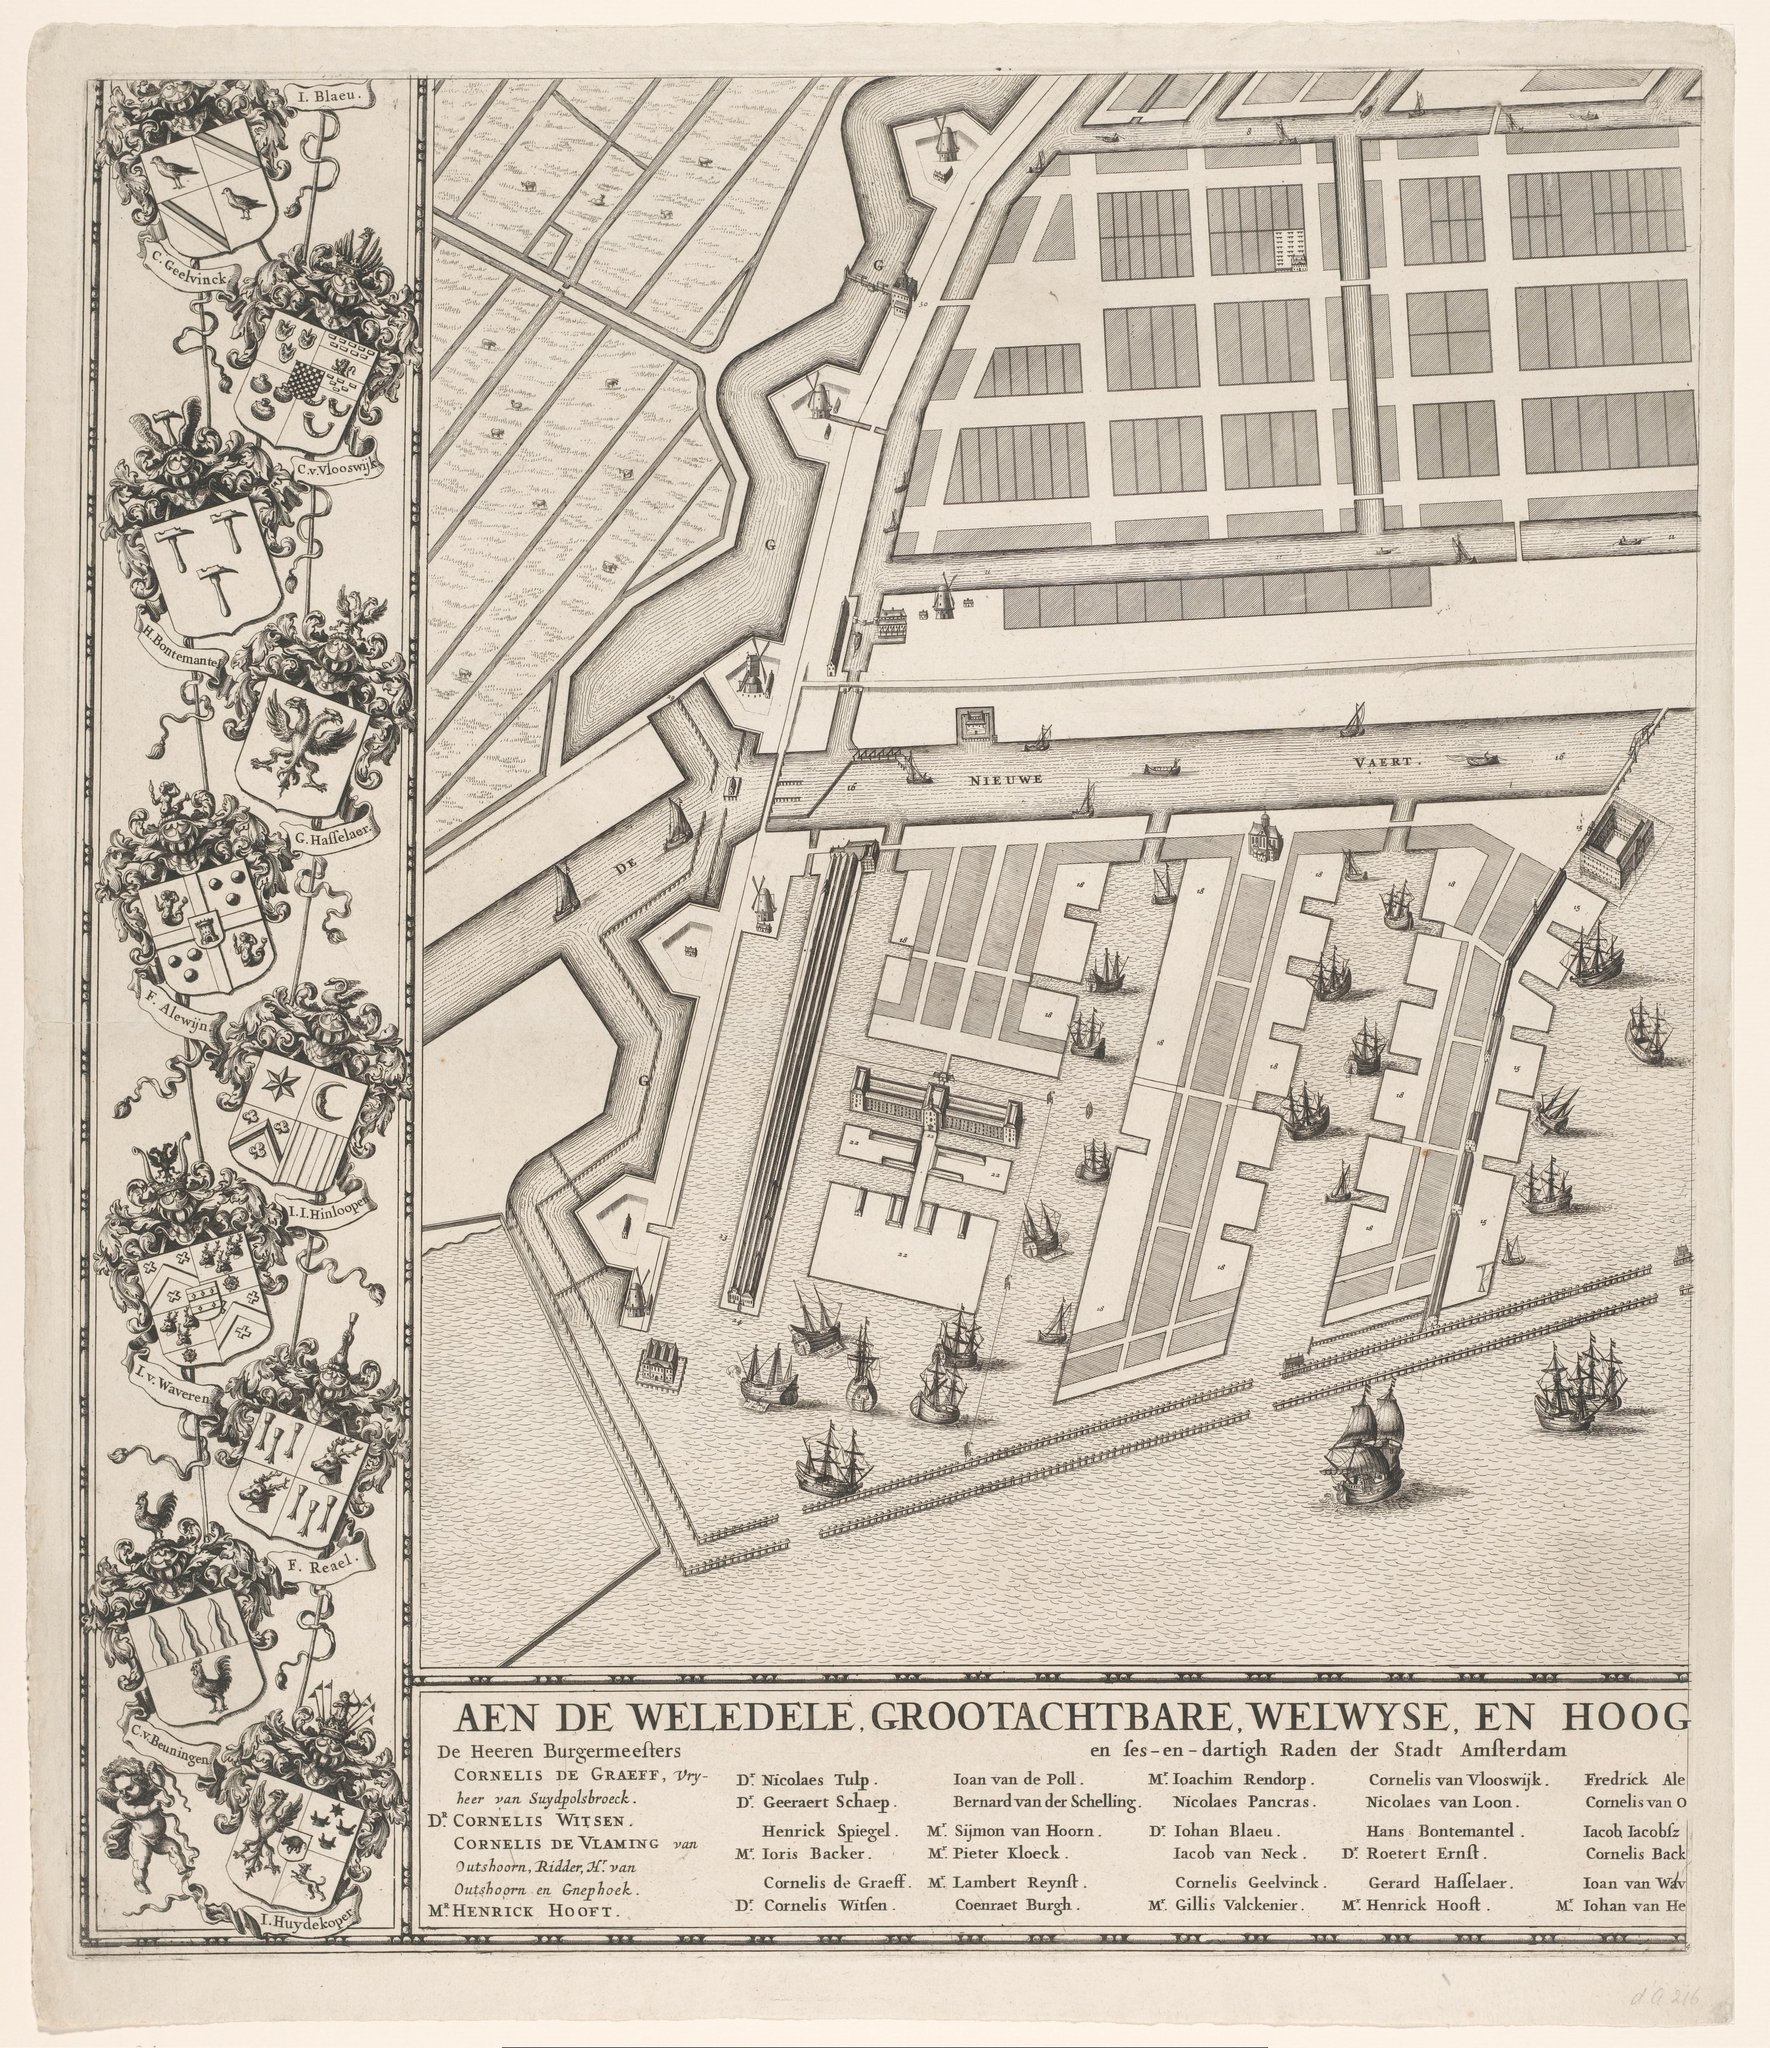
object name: print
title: Plattegrond van Amsterdam met ontwerp en uitvoering van de Vierde Uitleg (vierde deel)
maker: julius mülhüssen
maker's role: draughtsman, print maker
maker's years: 1611-1680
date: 1601-1663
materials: paper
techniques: engraving, etching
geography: amsterdam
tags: maps of cities, armorial bearing, heraldry, amsterdam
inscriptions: collector's mark: Lugt 195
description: Vierde deel van een plattegrond van Amsterdam met ontwerp en uitvoering van de Vierde Uitleg, bestaande uit zes delen. Rechtsonder genummerd: 4.